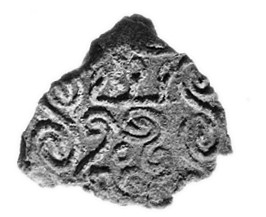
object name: sealing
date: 1981-1640 BCE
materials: mud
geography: egypt